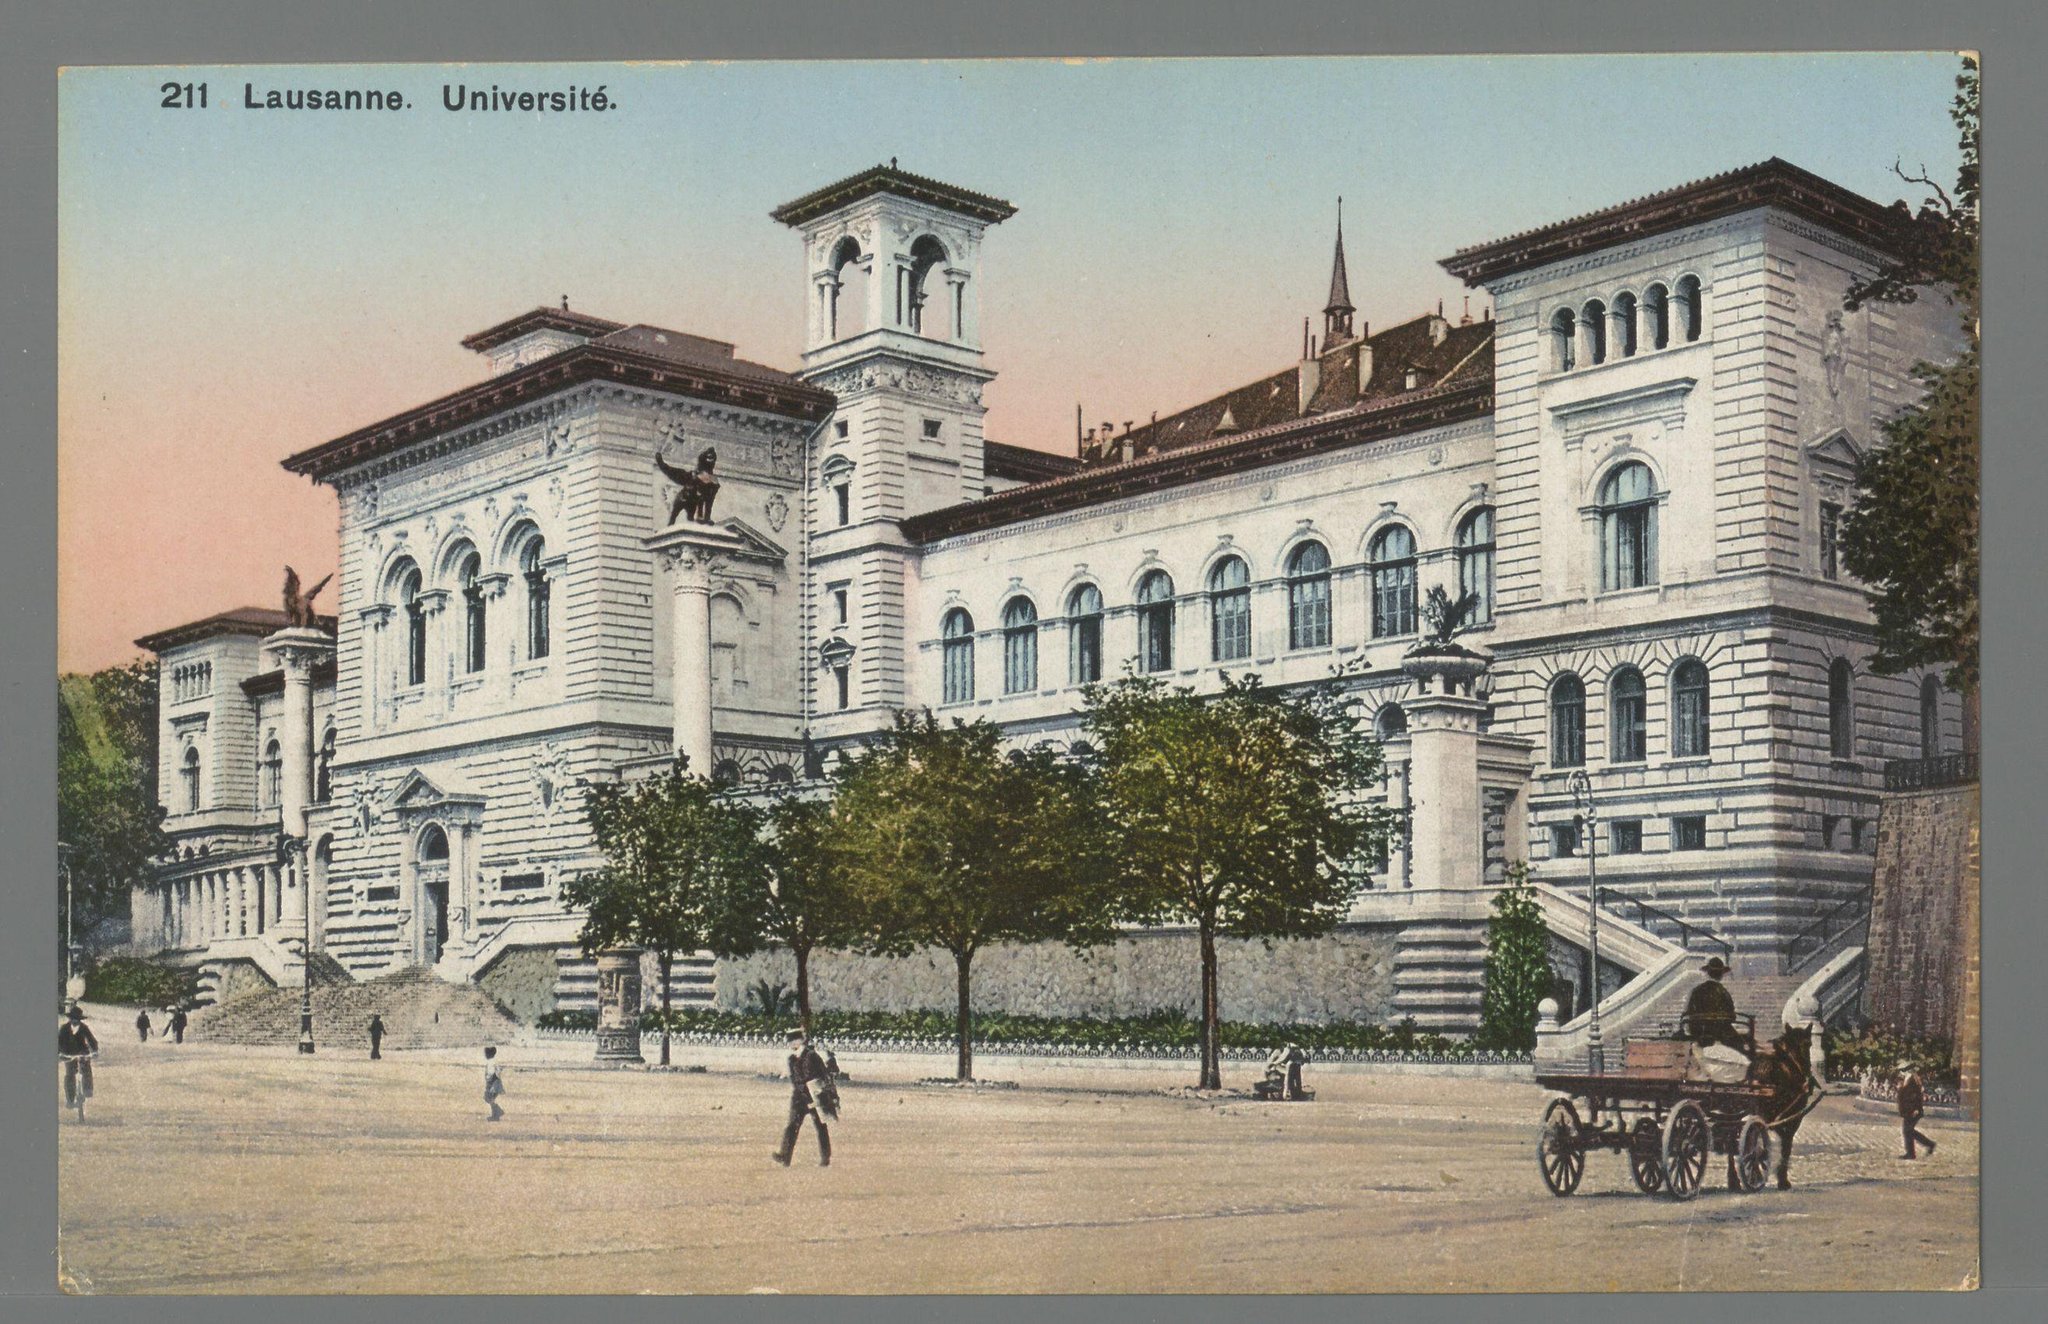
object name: photomechanical print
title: Lausanne. Université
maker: Anonymous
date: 1905-1920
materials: cardboard, photographic process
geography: lausanne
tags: four-wheeled vehicle drawn by one animal, university building, college, square, place, circus, etc. (+ city(-scape) with figures, staffage)